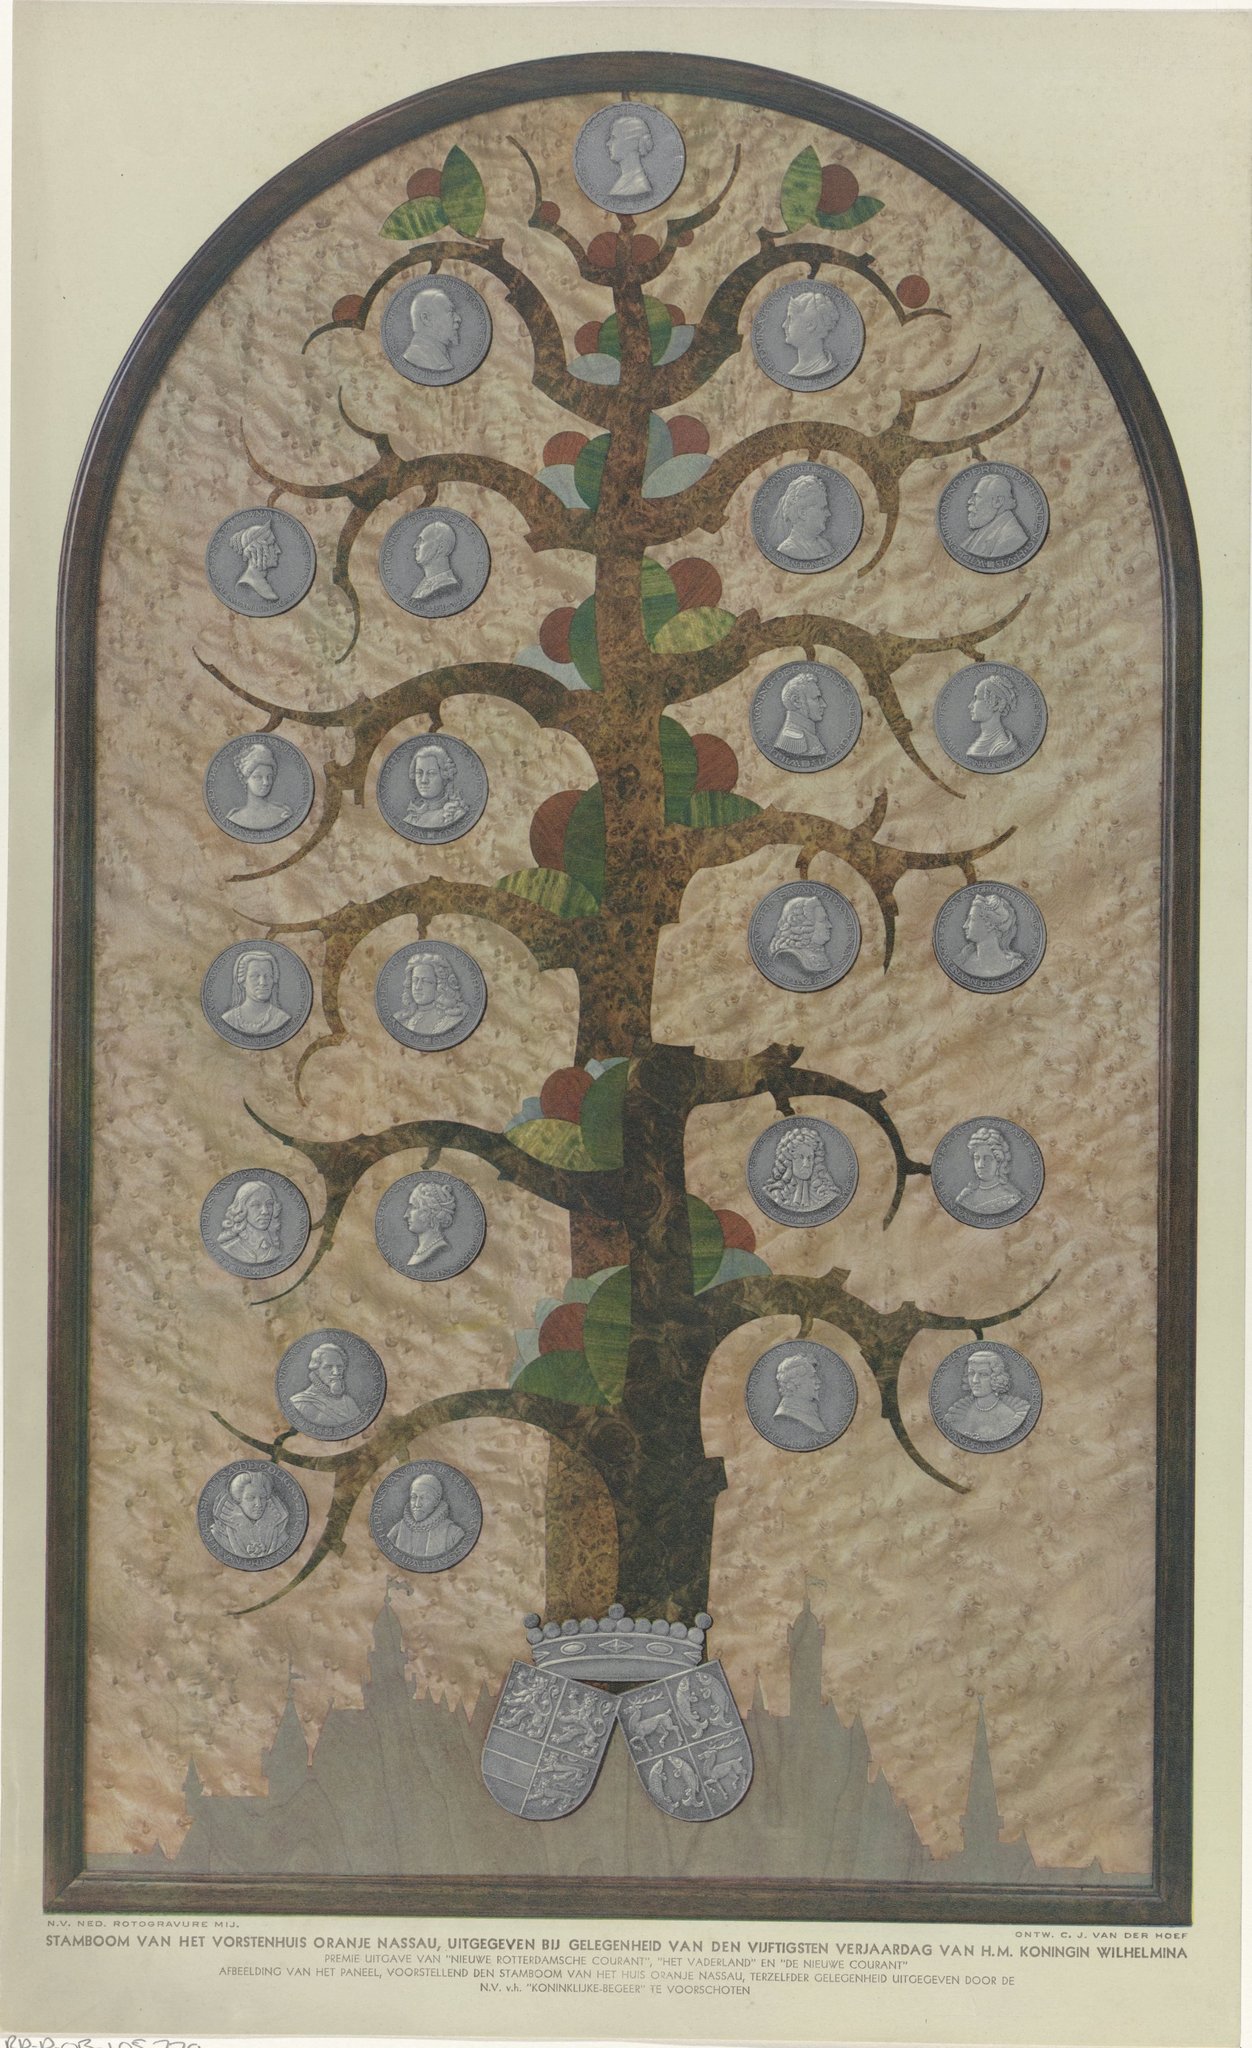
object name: photomechanical print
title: Stamboom van het Huis Oranje-Nassau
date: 1930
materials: paper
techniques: rotogravure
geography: netherlands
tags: anna paulowna romanowa, print maker, wilhelmina of the netherlands, hendrik (prins der nederlanden (1876-1934)), emma (queen consort of the netherlands), william v (prince of orange), johan willem friso (prins van oranje-nassau), louise de coligny, william i of the netherlands, brussels, willem iii (koning der nederlanden), william iii (prince of orange and king of england, scotland, and ireland), the hague, william ii of the netherlands, frederick henry (prince of orange), william ii (prince of orange), delft, william i (prince of orange), maurice (prince of orange), maria ii stuart (koningin van engeland, schotland en ierland), amalia of solms-braunfels, london, mary henrietta stuart, juliana of the netherlands, berlin, draughtsman, wilhelmina of prussia (princess of orange), willem iv (prins van oranje-nassau), anna van hannover, wilhelmina frederica louisa (koningin der nederlanden), family lineage, pedigree, genealogical tree or table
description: Stamboom van het Huis Oranje-Nassau, van Willem I tot en met Juliana. Aan de takken van een boom vierentwintig portretten, elk in een cirkel met randschrift. Midden onder twee wapens met een kroon. In de ondermarge een regel Nederlandse tekst. Vervaardigd ter gelegenheid van de viering van de vijftigste verjaardag van Wilhelmina op 31 augustus 1930. Premieplaat van de 'Nieuwe Rotterdamsche Courant', 'Het Vaderland' en de 'Nieuwe Courant'.